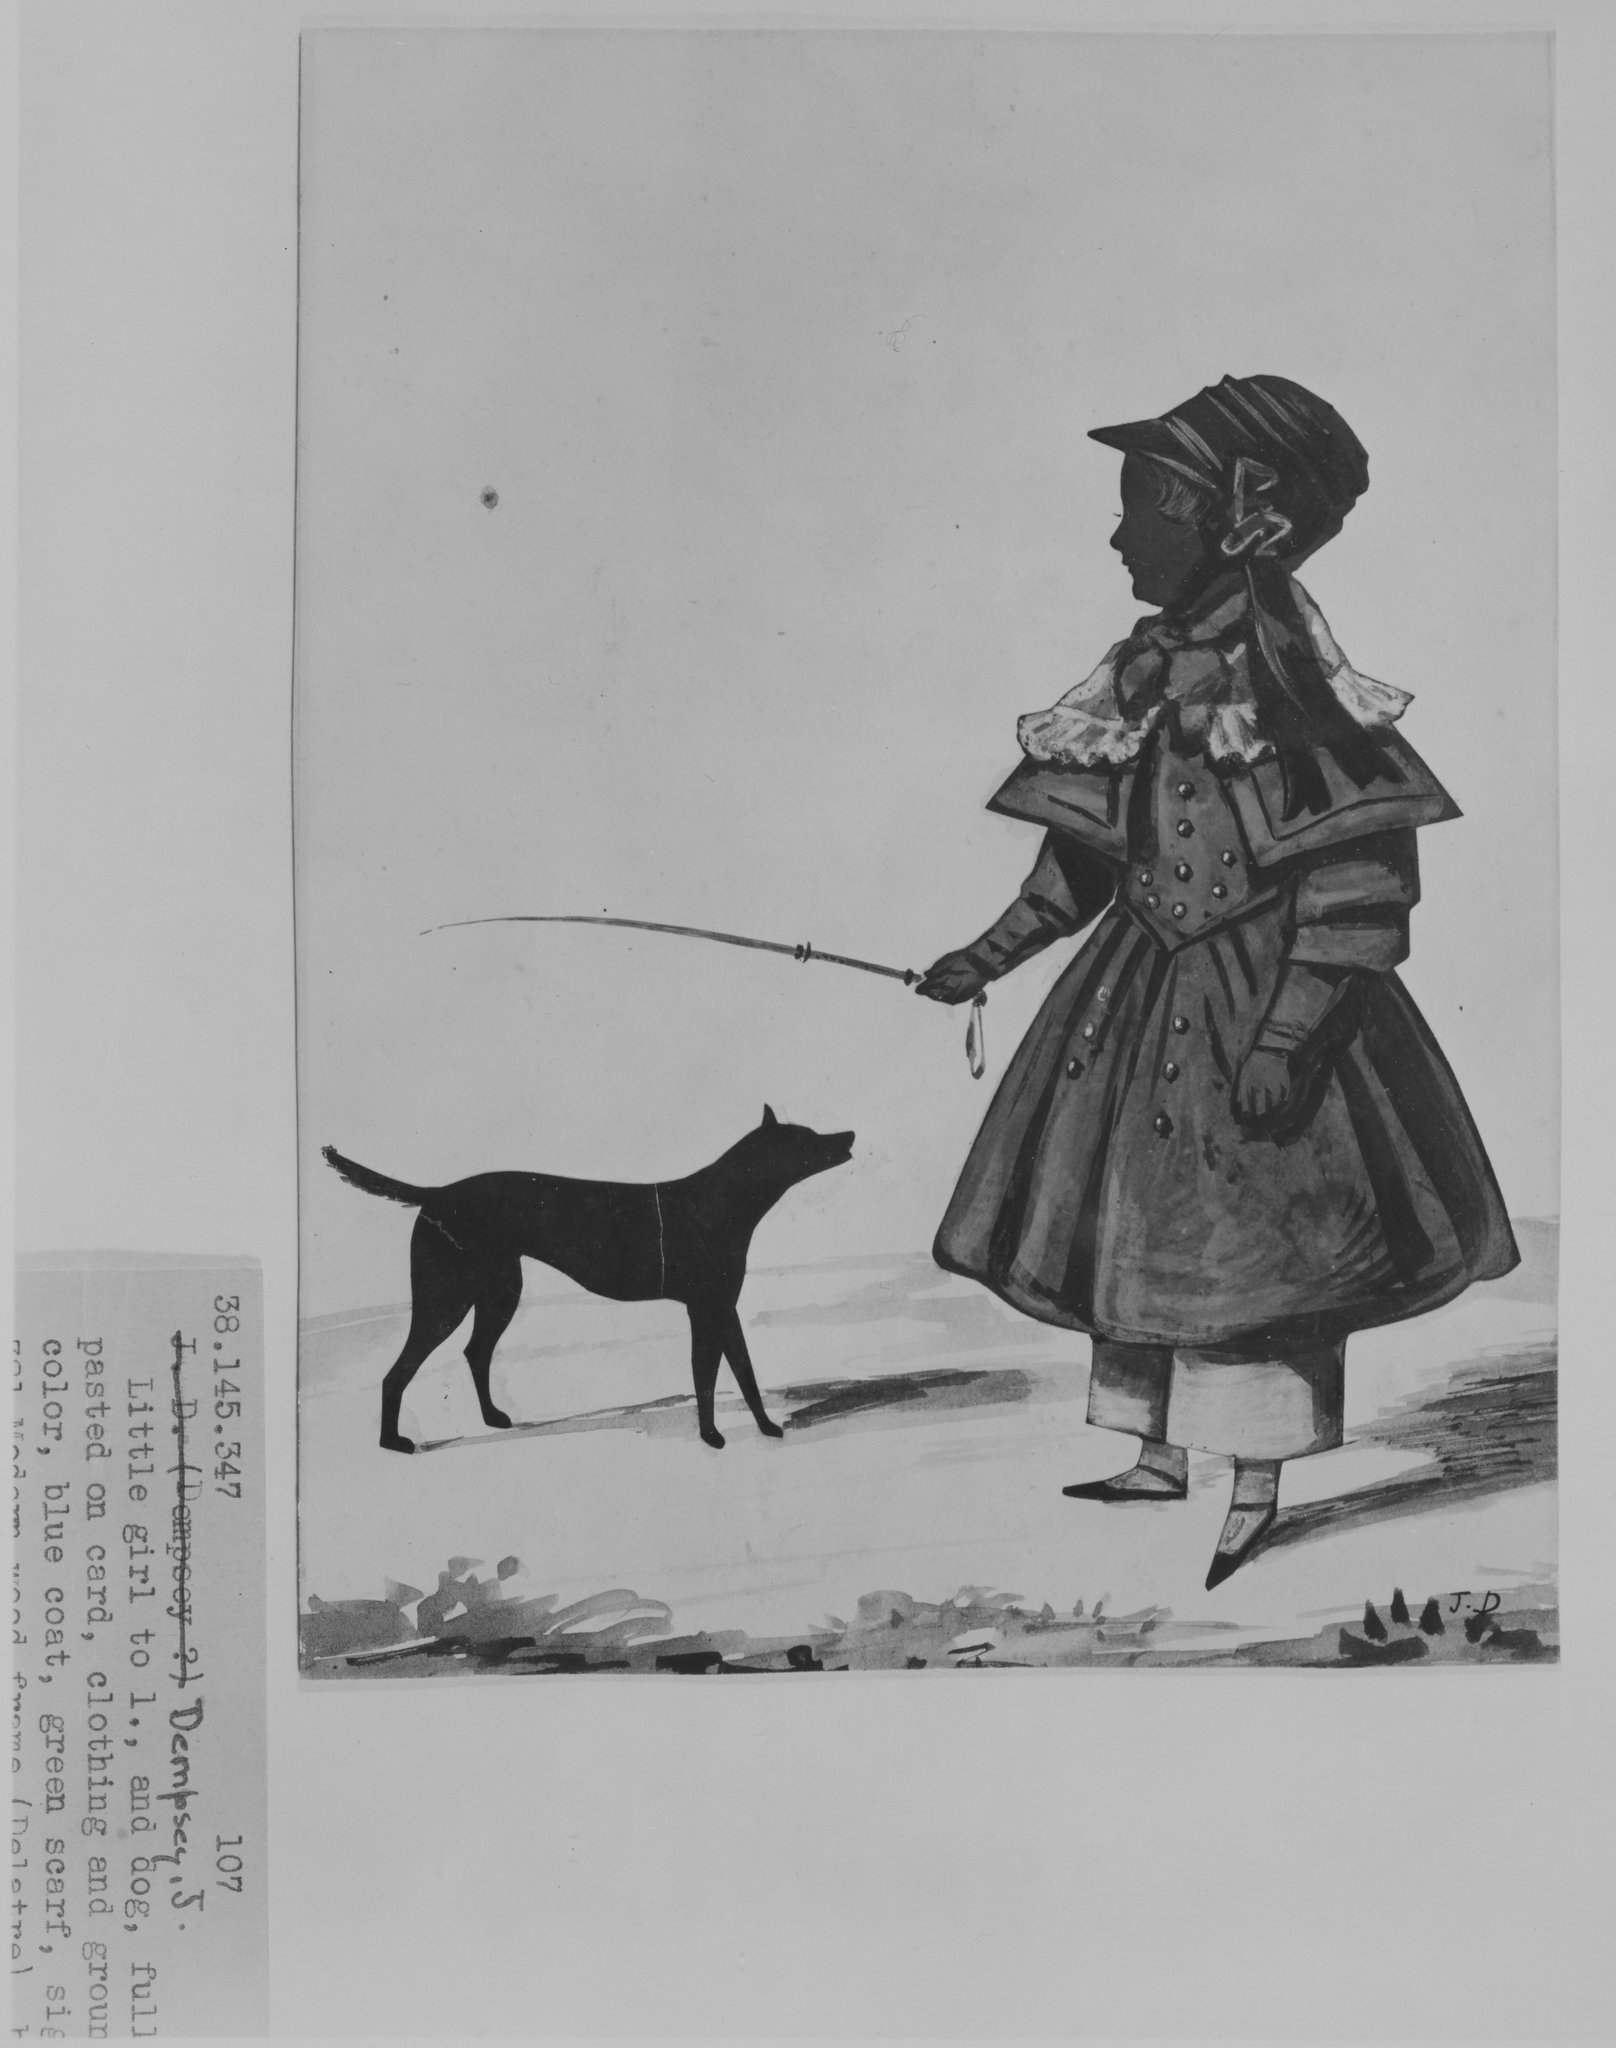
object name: cut paper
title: Silhouette of a little girl and dog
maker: john dempsey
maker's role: artist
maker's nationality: british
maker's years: 1832-1844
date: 1832-1844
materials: paper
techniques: cutting, painting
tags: girls,dogs